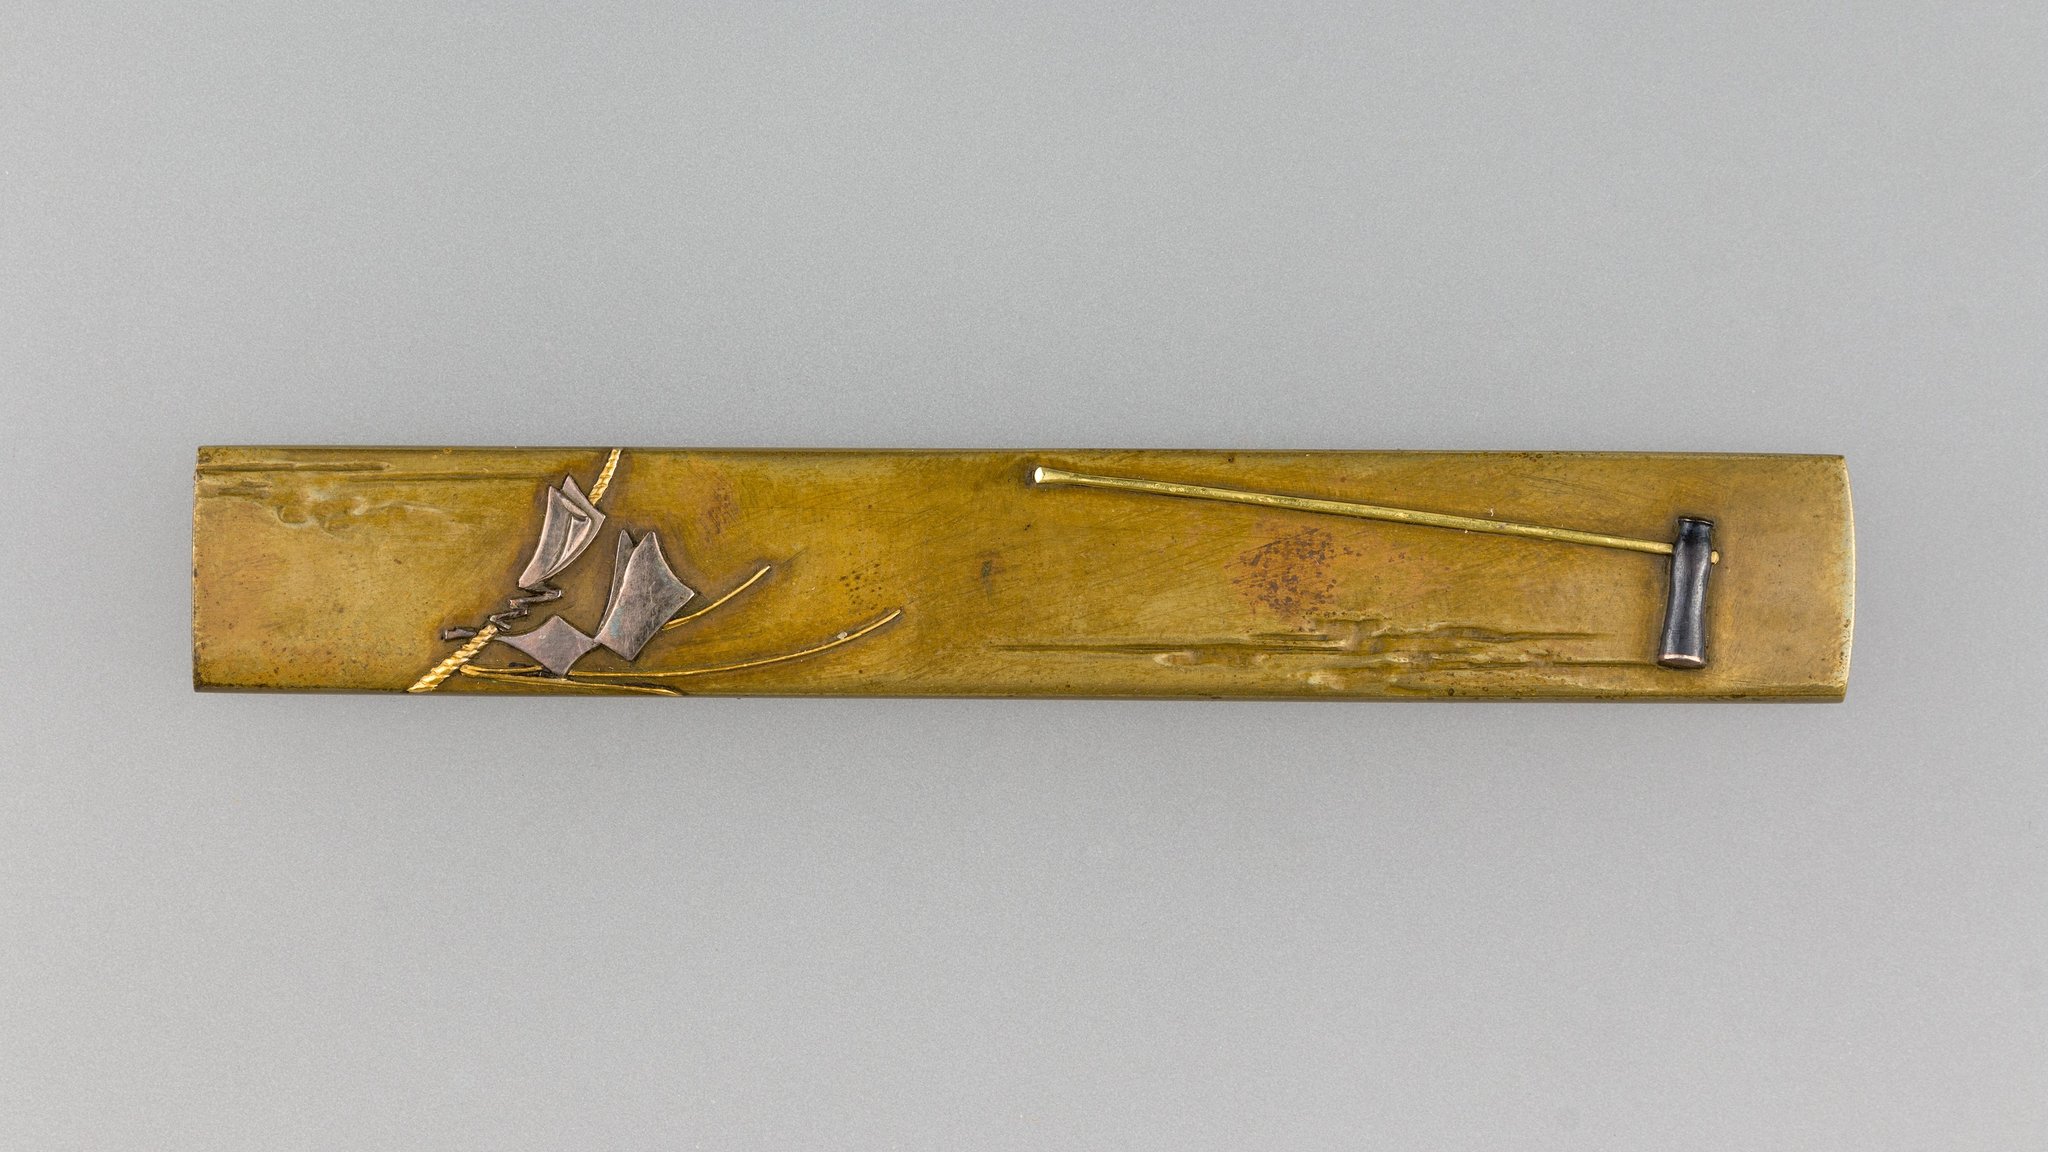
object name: knife handle kozuka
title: Knife Handle (Kozuka)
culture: japanese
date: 1701-1800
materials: brass, copper, gold alloy, silver alloy, gold, silver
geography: japan